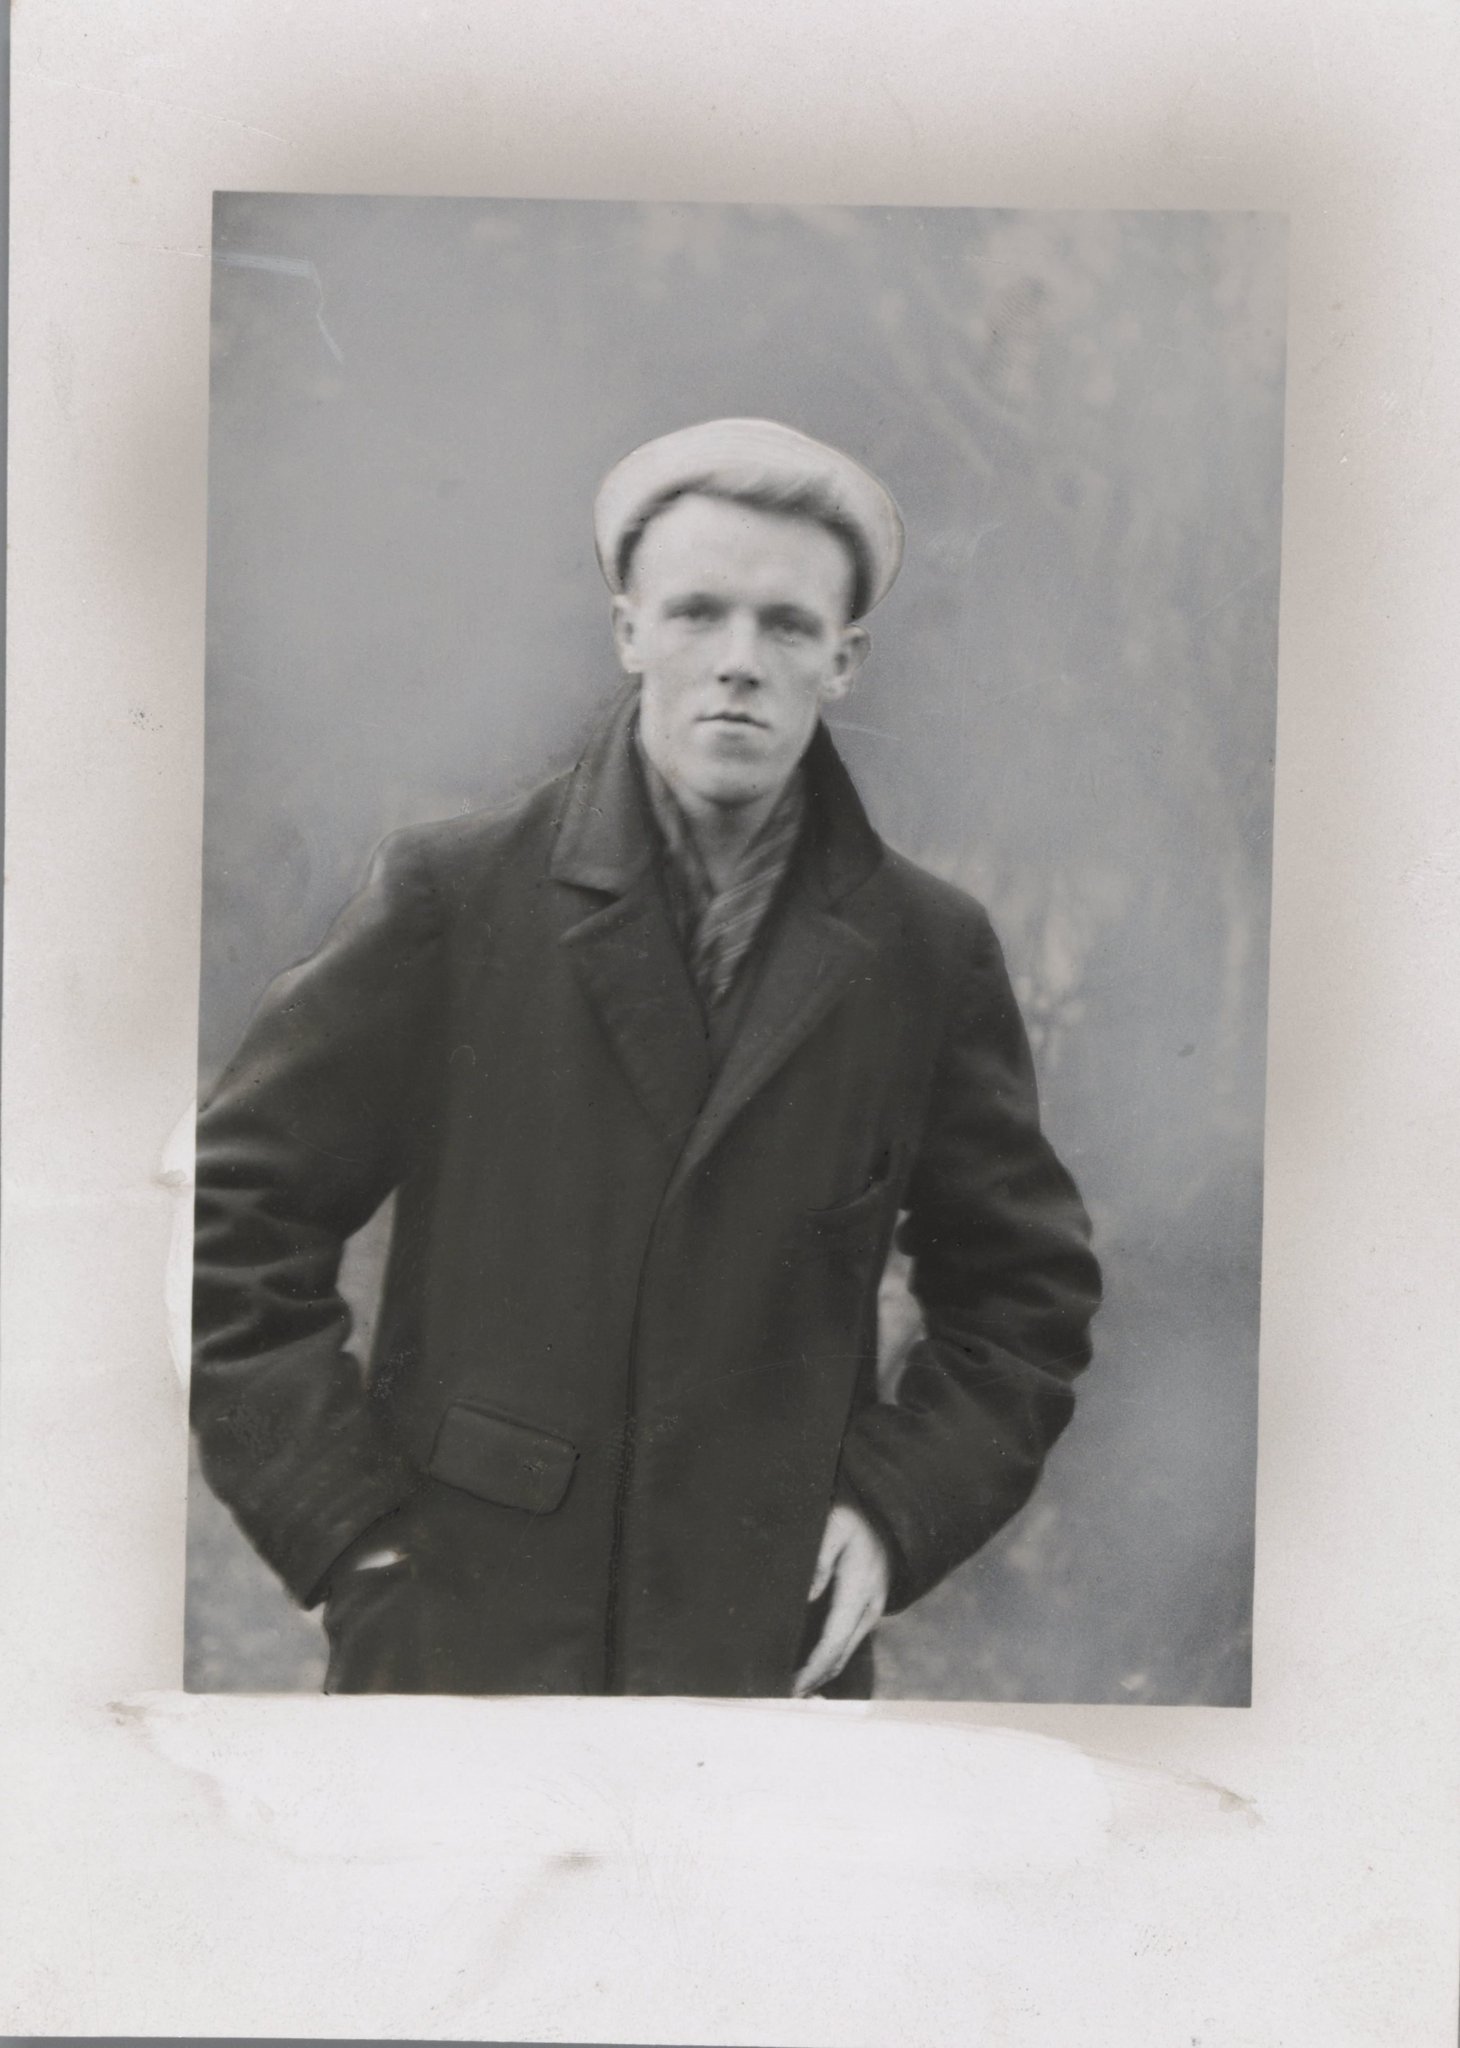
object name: photograph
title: Reproductie naar een foto, schilderij, tekening of prent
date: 1860-1915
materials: paper, photographic support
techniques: gelatin silver print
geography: netherlands